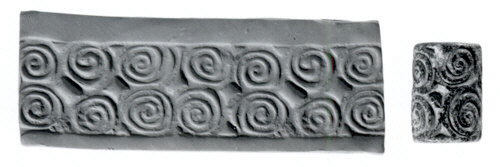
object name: cylinder seal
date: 3100-2700 BCE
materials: mineral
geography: mesopotamia or syria